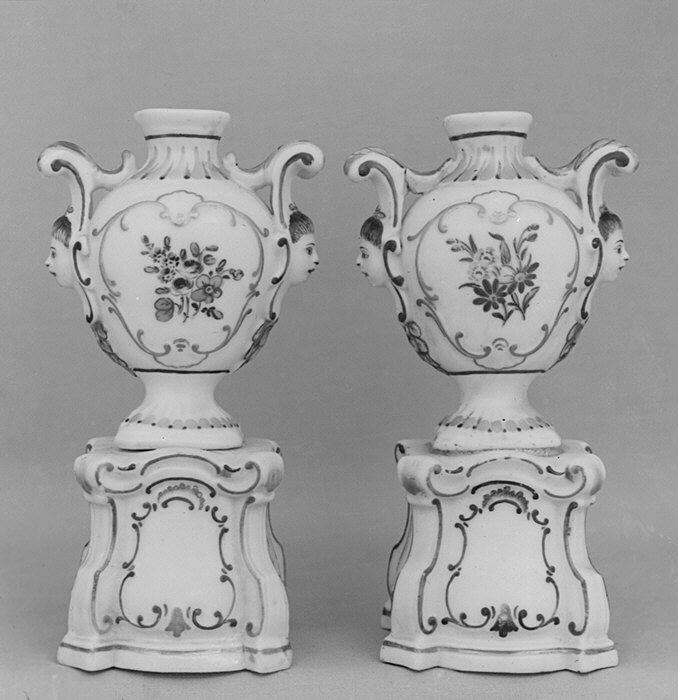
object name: vase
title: Pair of small vases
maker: doccia porcelain manufactory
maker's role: manufactory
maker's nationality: italian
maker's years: 1737-1896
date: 1770-1780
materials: hard paste porcelain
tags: flowers